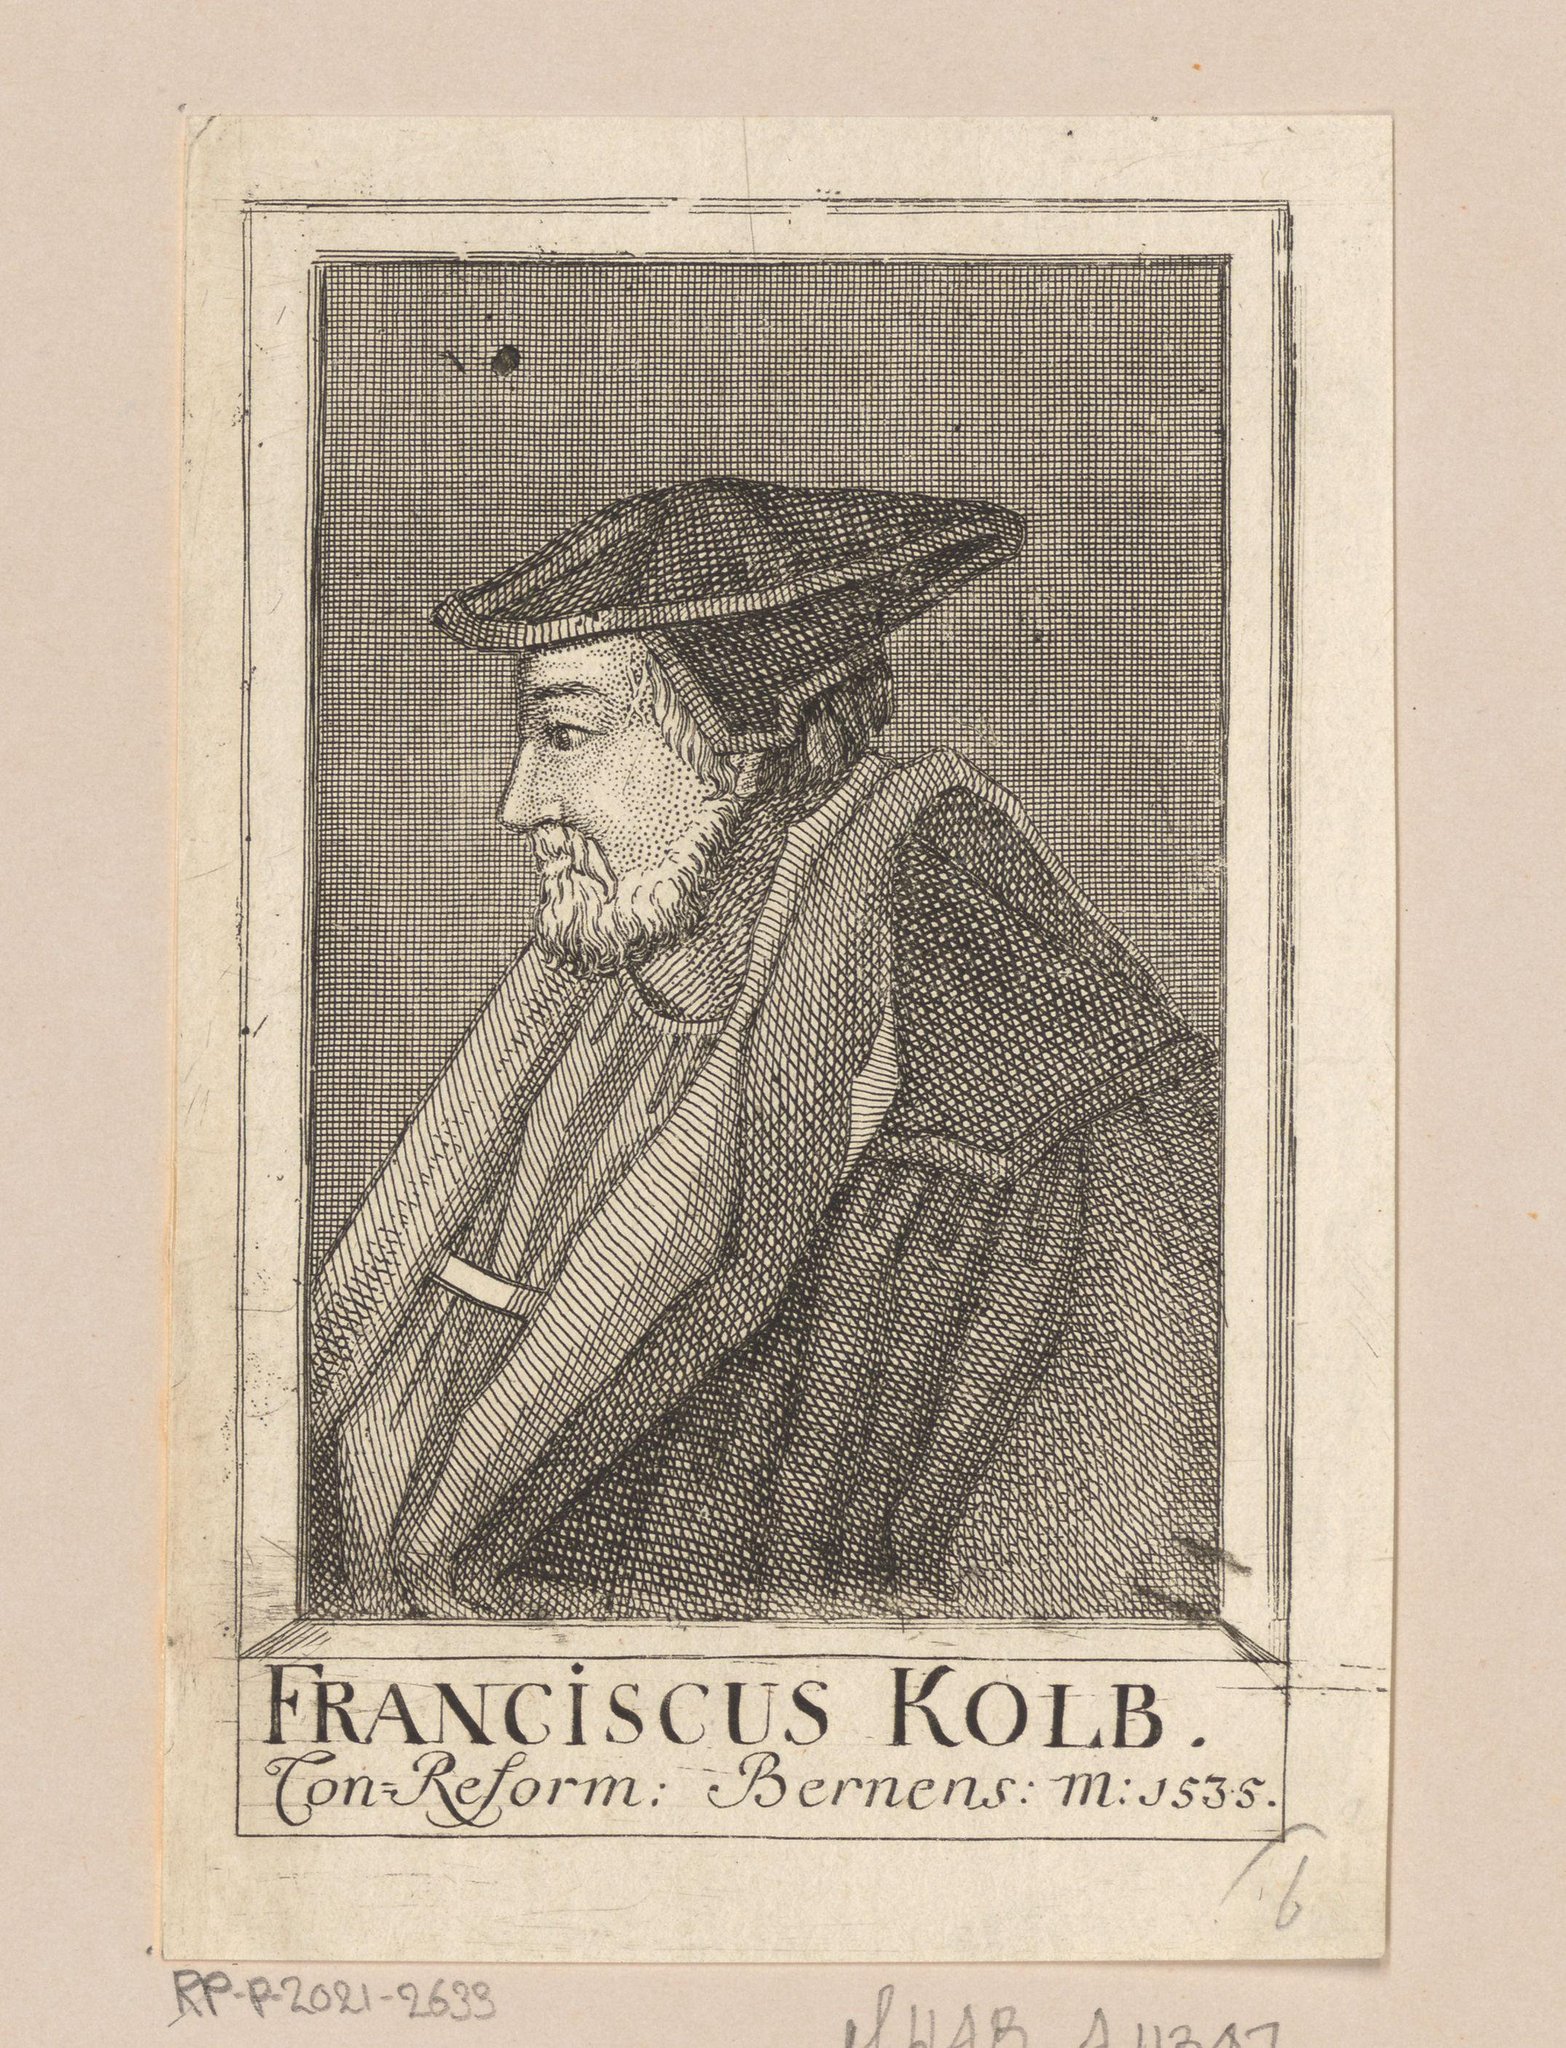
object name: print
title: Portret van Franz Kolb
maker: Anonymous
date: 1743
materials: paper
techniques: engraving, etching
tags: theologian, historical persons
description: Prent mogelijk uit: Scheurer, Samuel. Bernerisches Mausoleum. Bern: Jeanne Esther Bondeli, 1743.